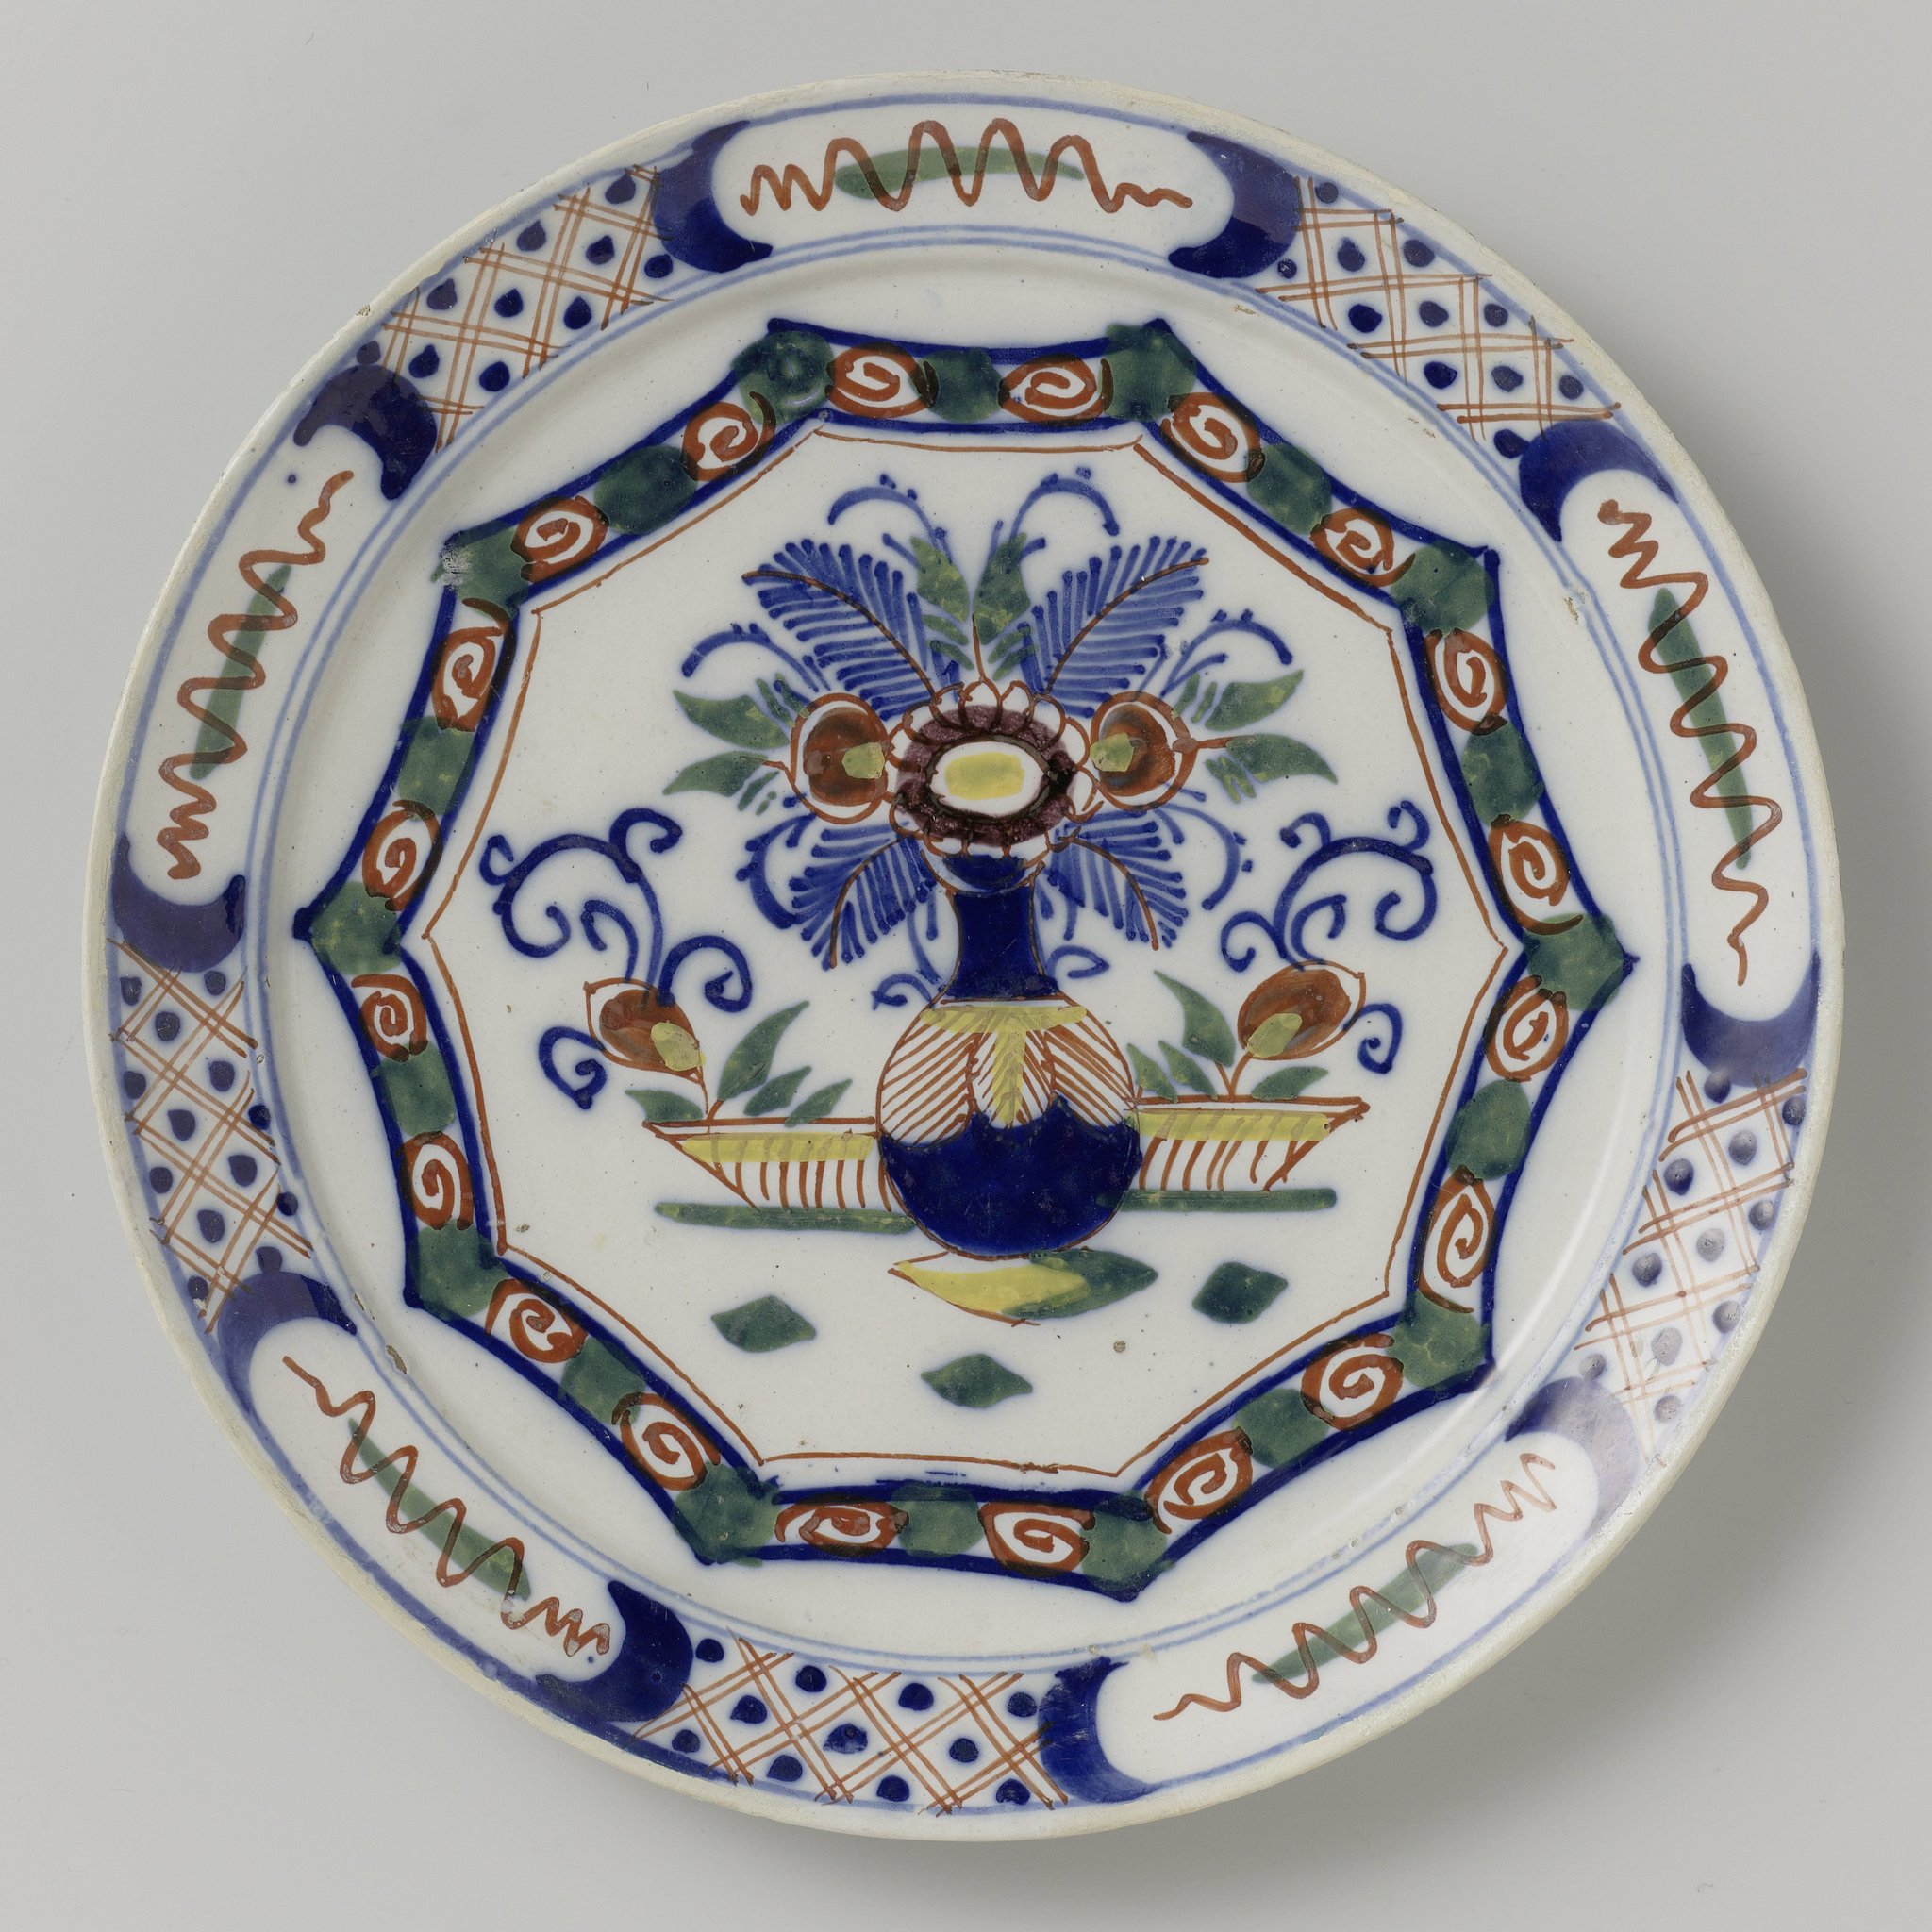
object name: plate dish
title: bord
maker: Anonymous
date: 1730-1760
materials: earthenware, glaze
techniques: painted, polychromy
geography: delft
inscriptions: seal: ‘koninklijk oudheidkundig genootschap no. 41’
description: Rond bord van veelkleurig beschilderd faience, met op het plat een vaas met bloemen voor een schaal met bloemen in de kleuren groen, rood, blauw en geel en daar omheen een tienhoekige rand in de kleuren groen en rood. Op de rand van het bord is een Chinees motief geschilderd. Bij het bord horen twee identieke borden met invnrs. BK-KOG-2427-a en BK-KOG-2427-b.